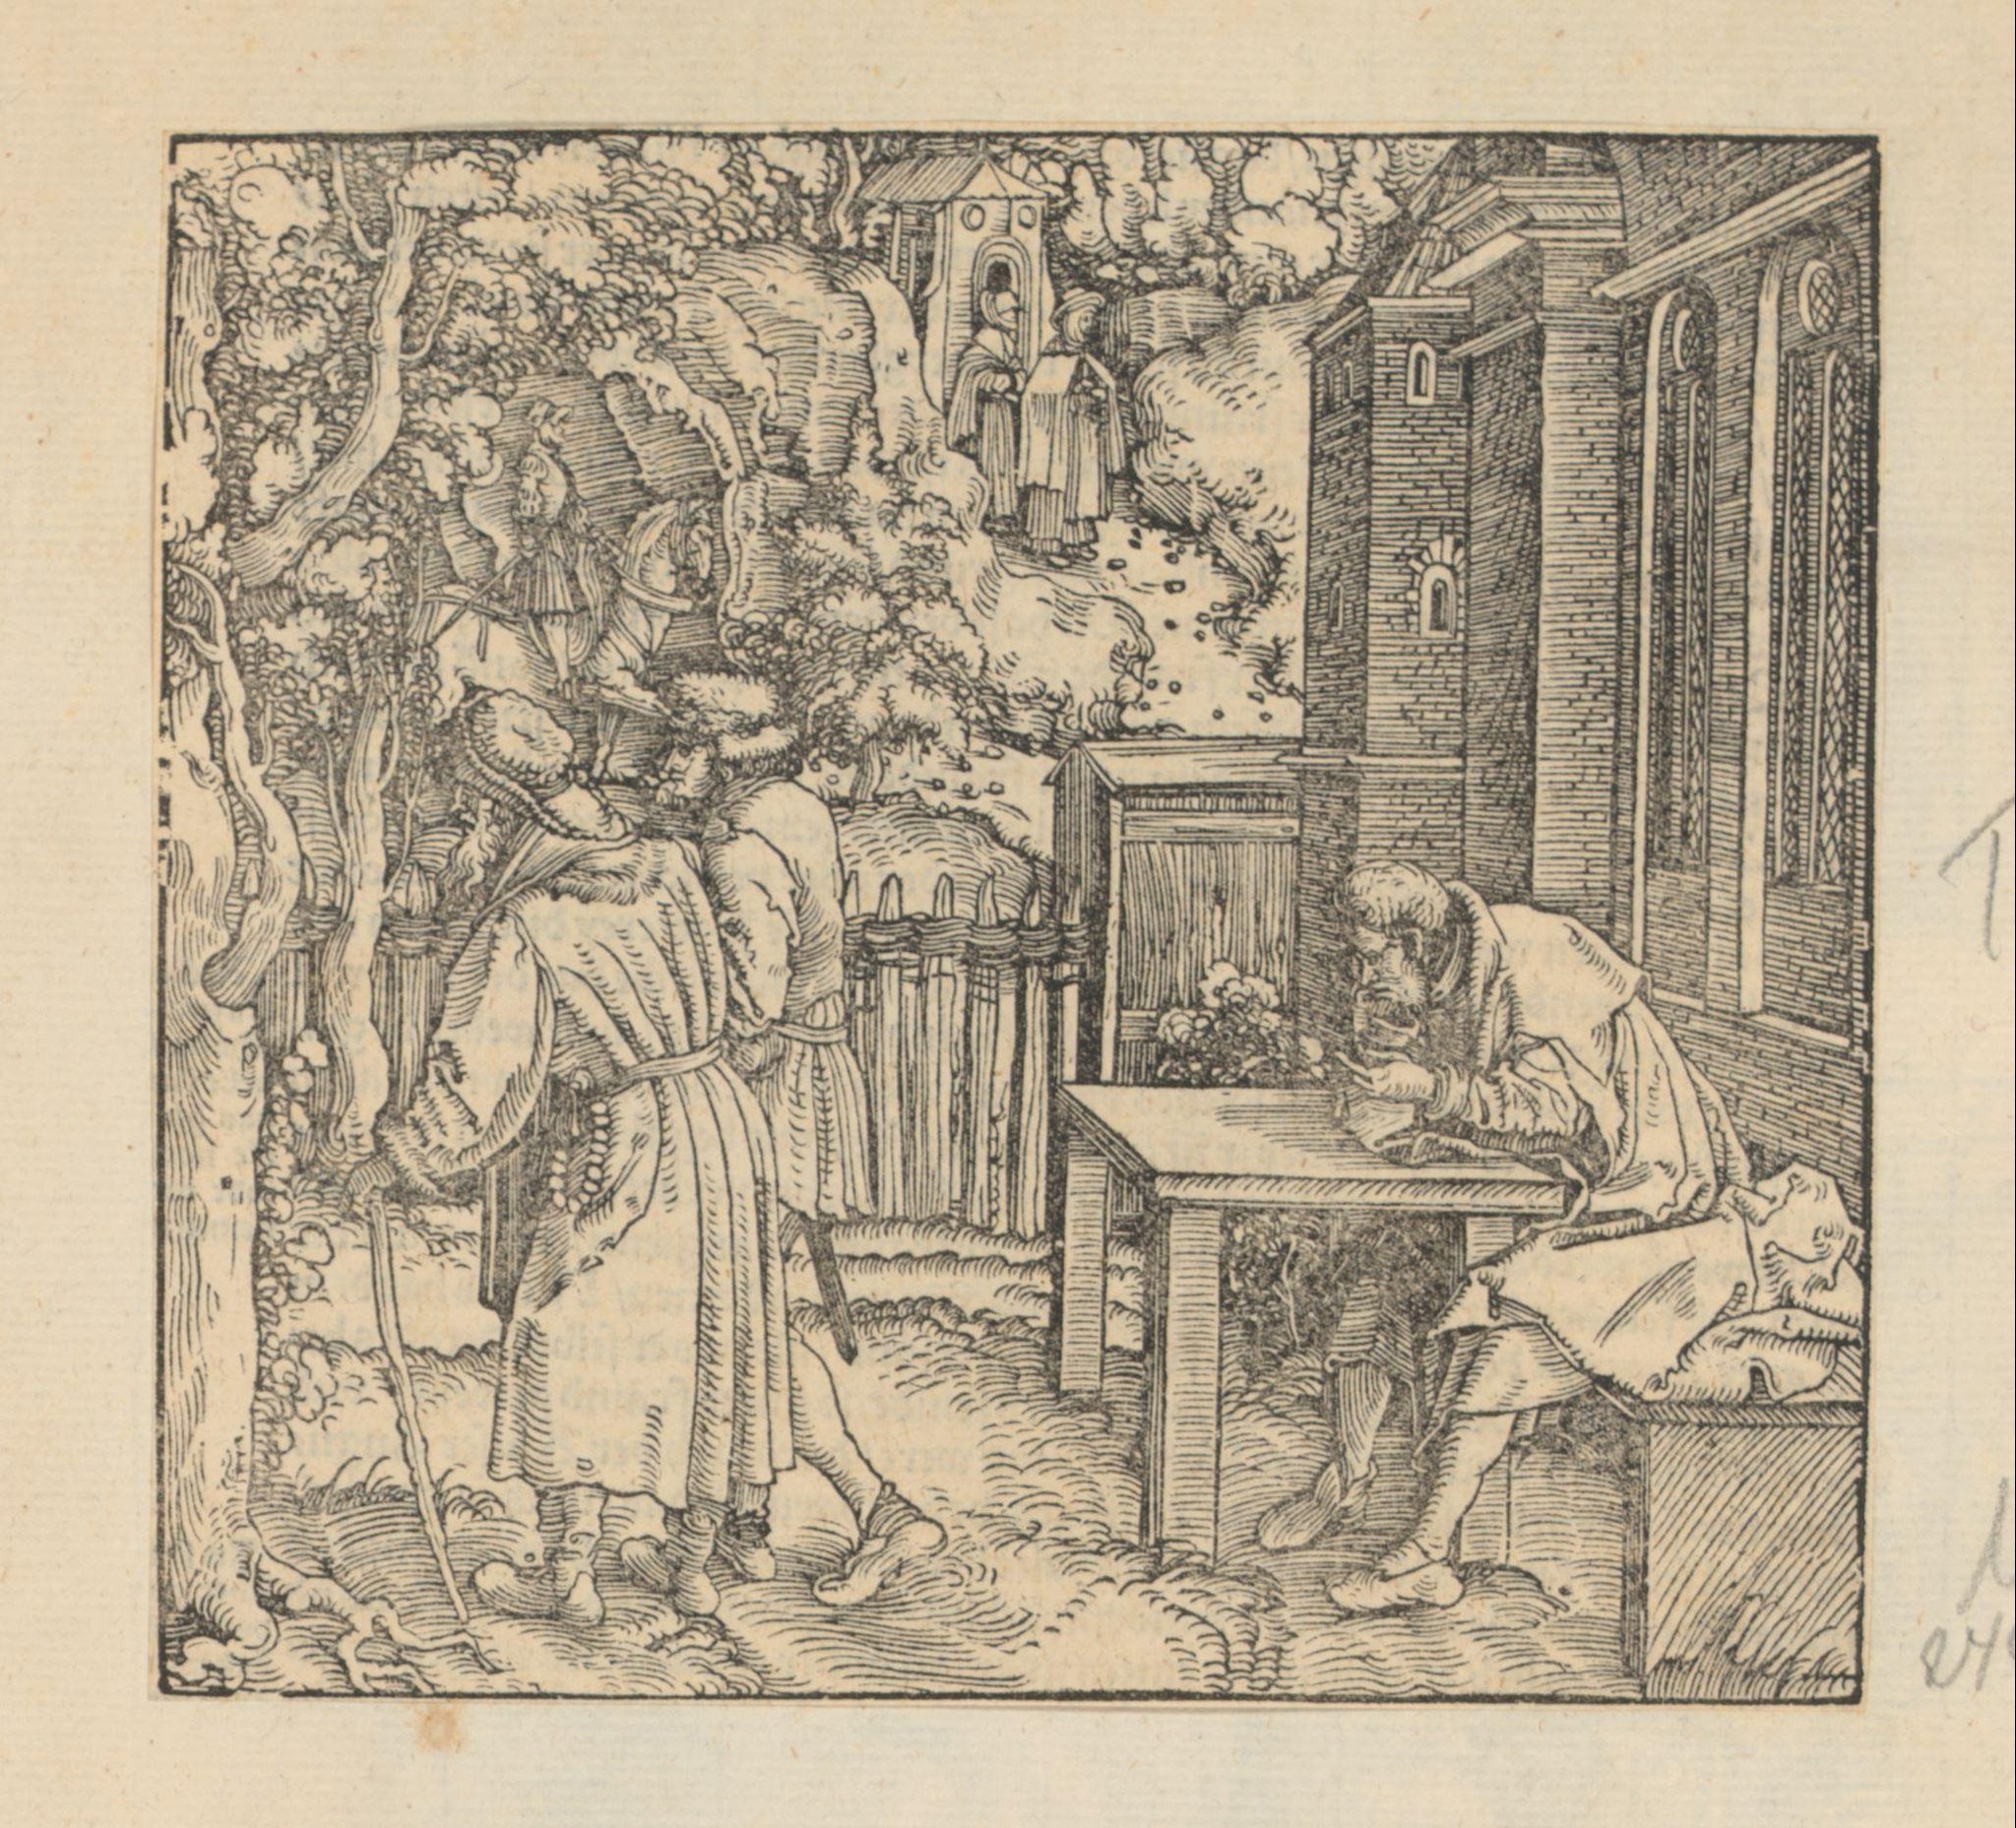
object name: album leaf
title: Drie mannen bij een huis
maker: Anonymous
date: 1514-1532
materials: paper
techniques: letterpress printing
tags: friends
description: Deze prent is gebruikt in: Petrarca, Francesco. Von der Artzney bayder Glück, des guten und widerwertigen: unnd weß sich ain yeder inn Gelück und Unglück halten sol (...). Augsburg: Heinrich Steiner, 1532. Deze uitgave is ook bekend onder de titel 'Trostspiegel in Glück und Unglück'.